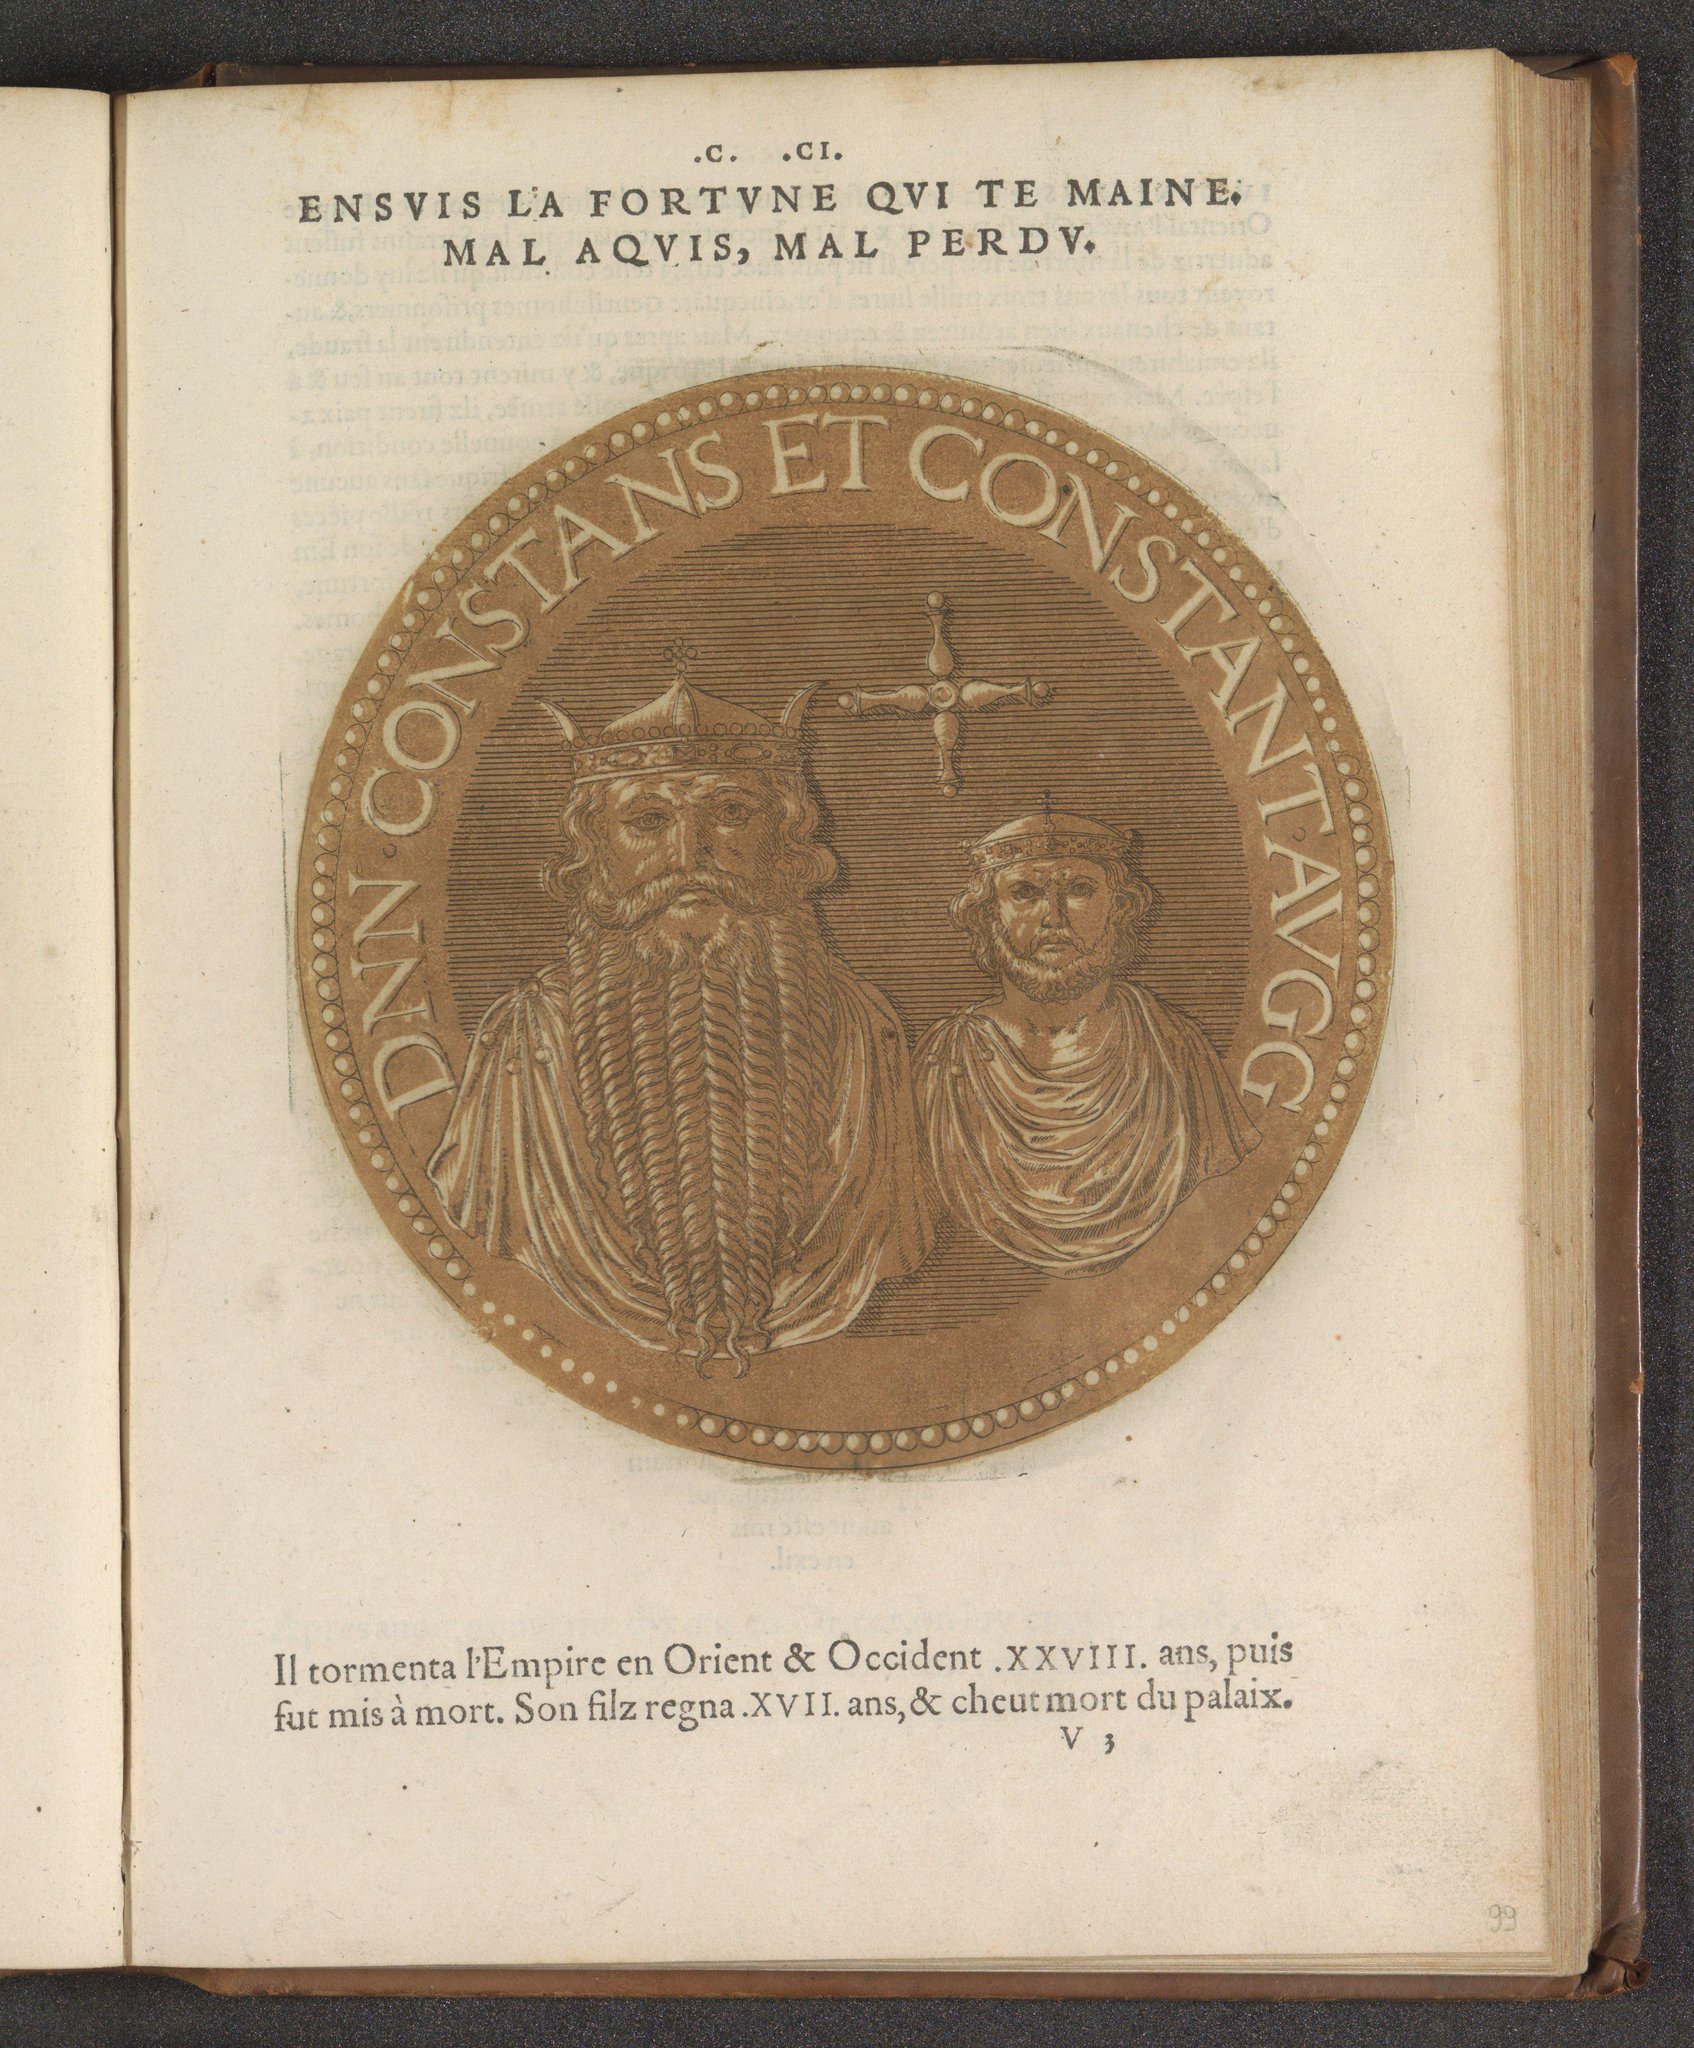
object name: print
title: Les images presque de tous les empereurs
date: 1557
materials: paper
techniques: woodcut, etching, letterpress printing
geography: antwerp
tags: emperor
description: Portretten van keizer Constantijn III en zijn zoon Constans II, samen op een munt met randschrift. De prent maakt deel uit van een boek over de keizers vanaf Julius Caesar tot en met Karel V en zijn broer Ferdinand.